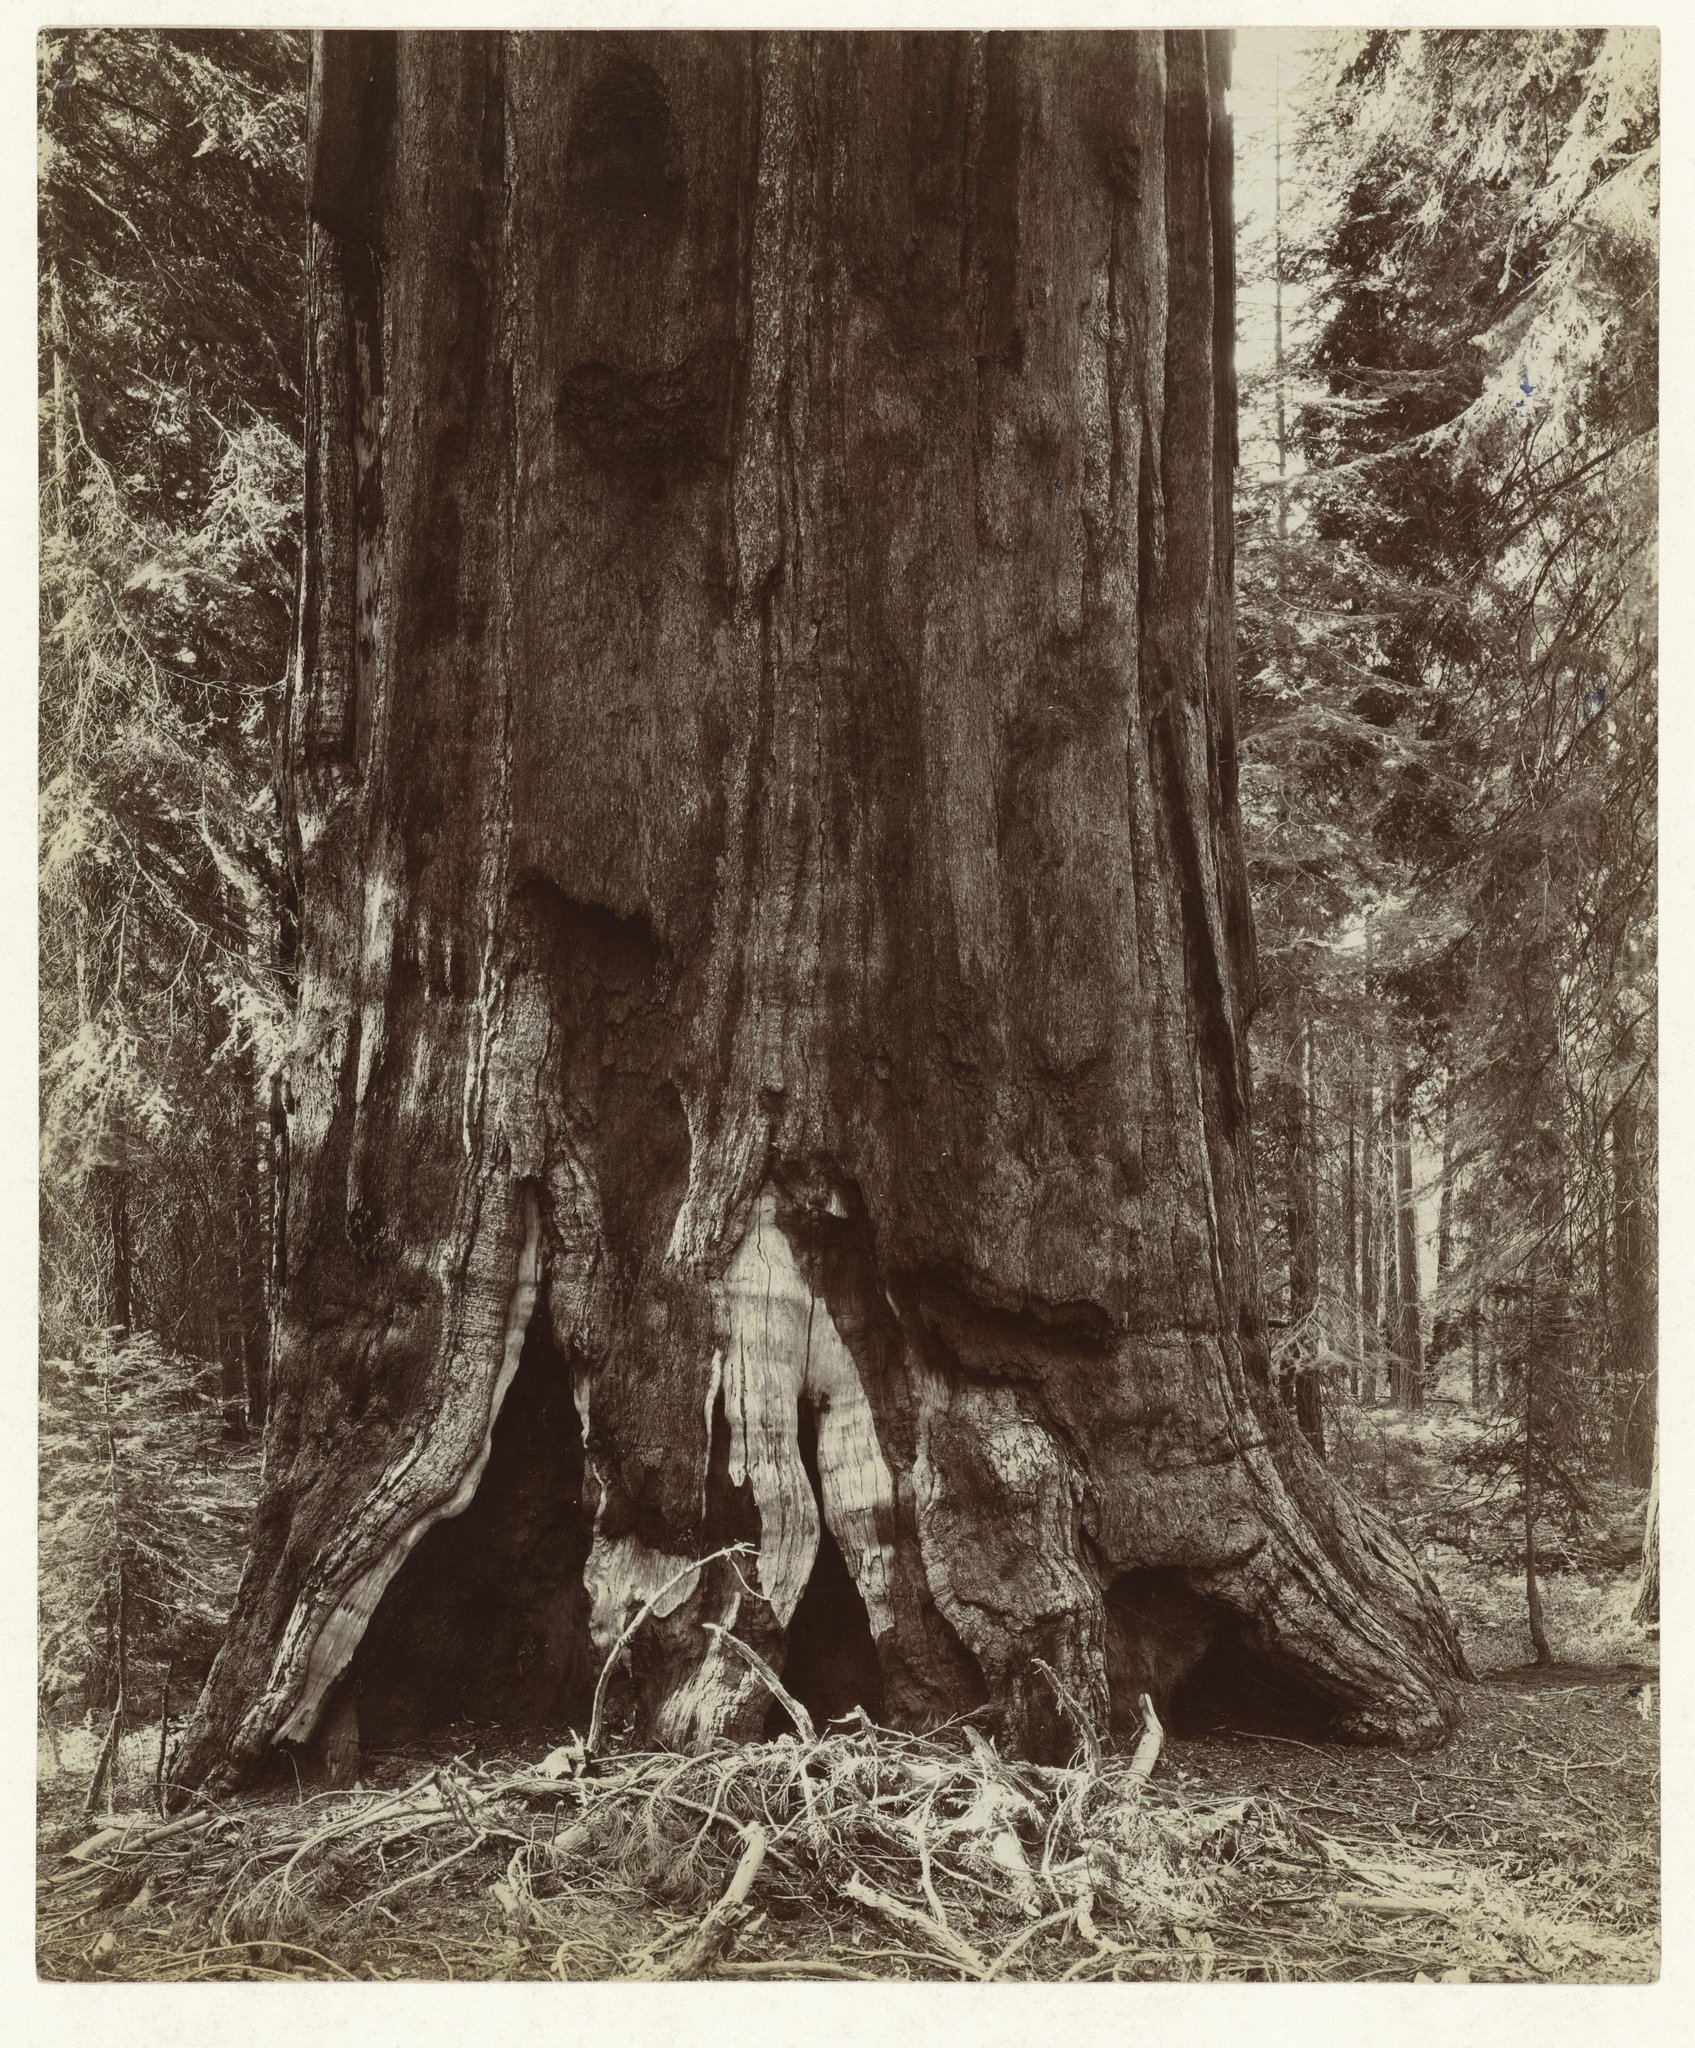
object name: photograph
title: Stam van een mammoetboom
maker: Anonymous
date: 1880-1920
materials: paper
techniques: gelatin silver print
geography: san francisco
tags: trees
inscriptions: inscription: ‘The Stibbard Grant Forest, California’, stamp: ‘On Line Southern Pacific’, number: ‘13398’